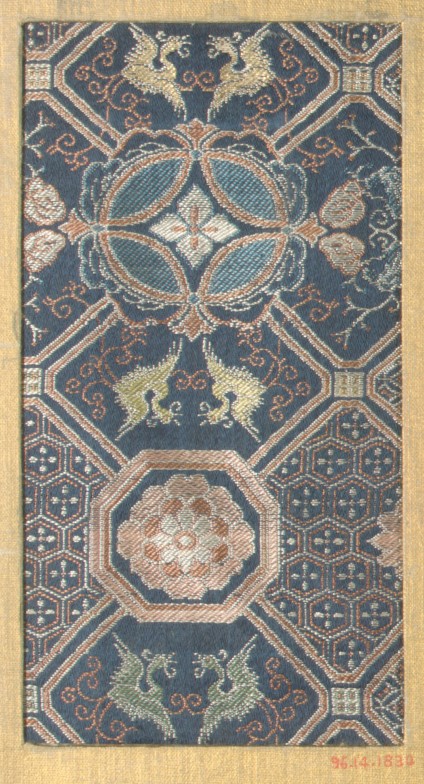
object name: piece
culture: japanese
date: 1701-1900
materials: silk